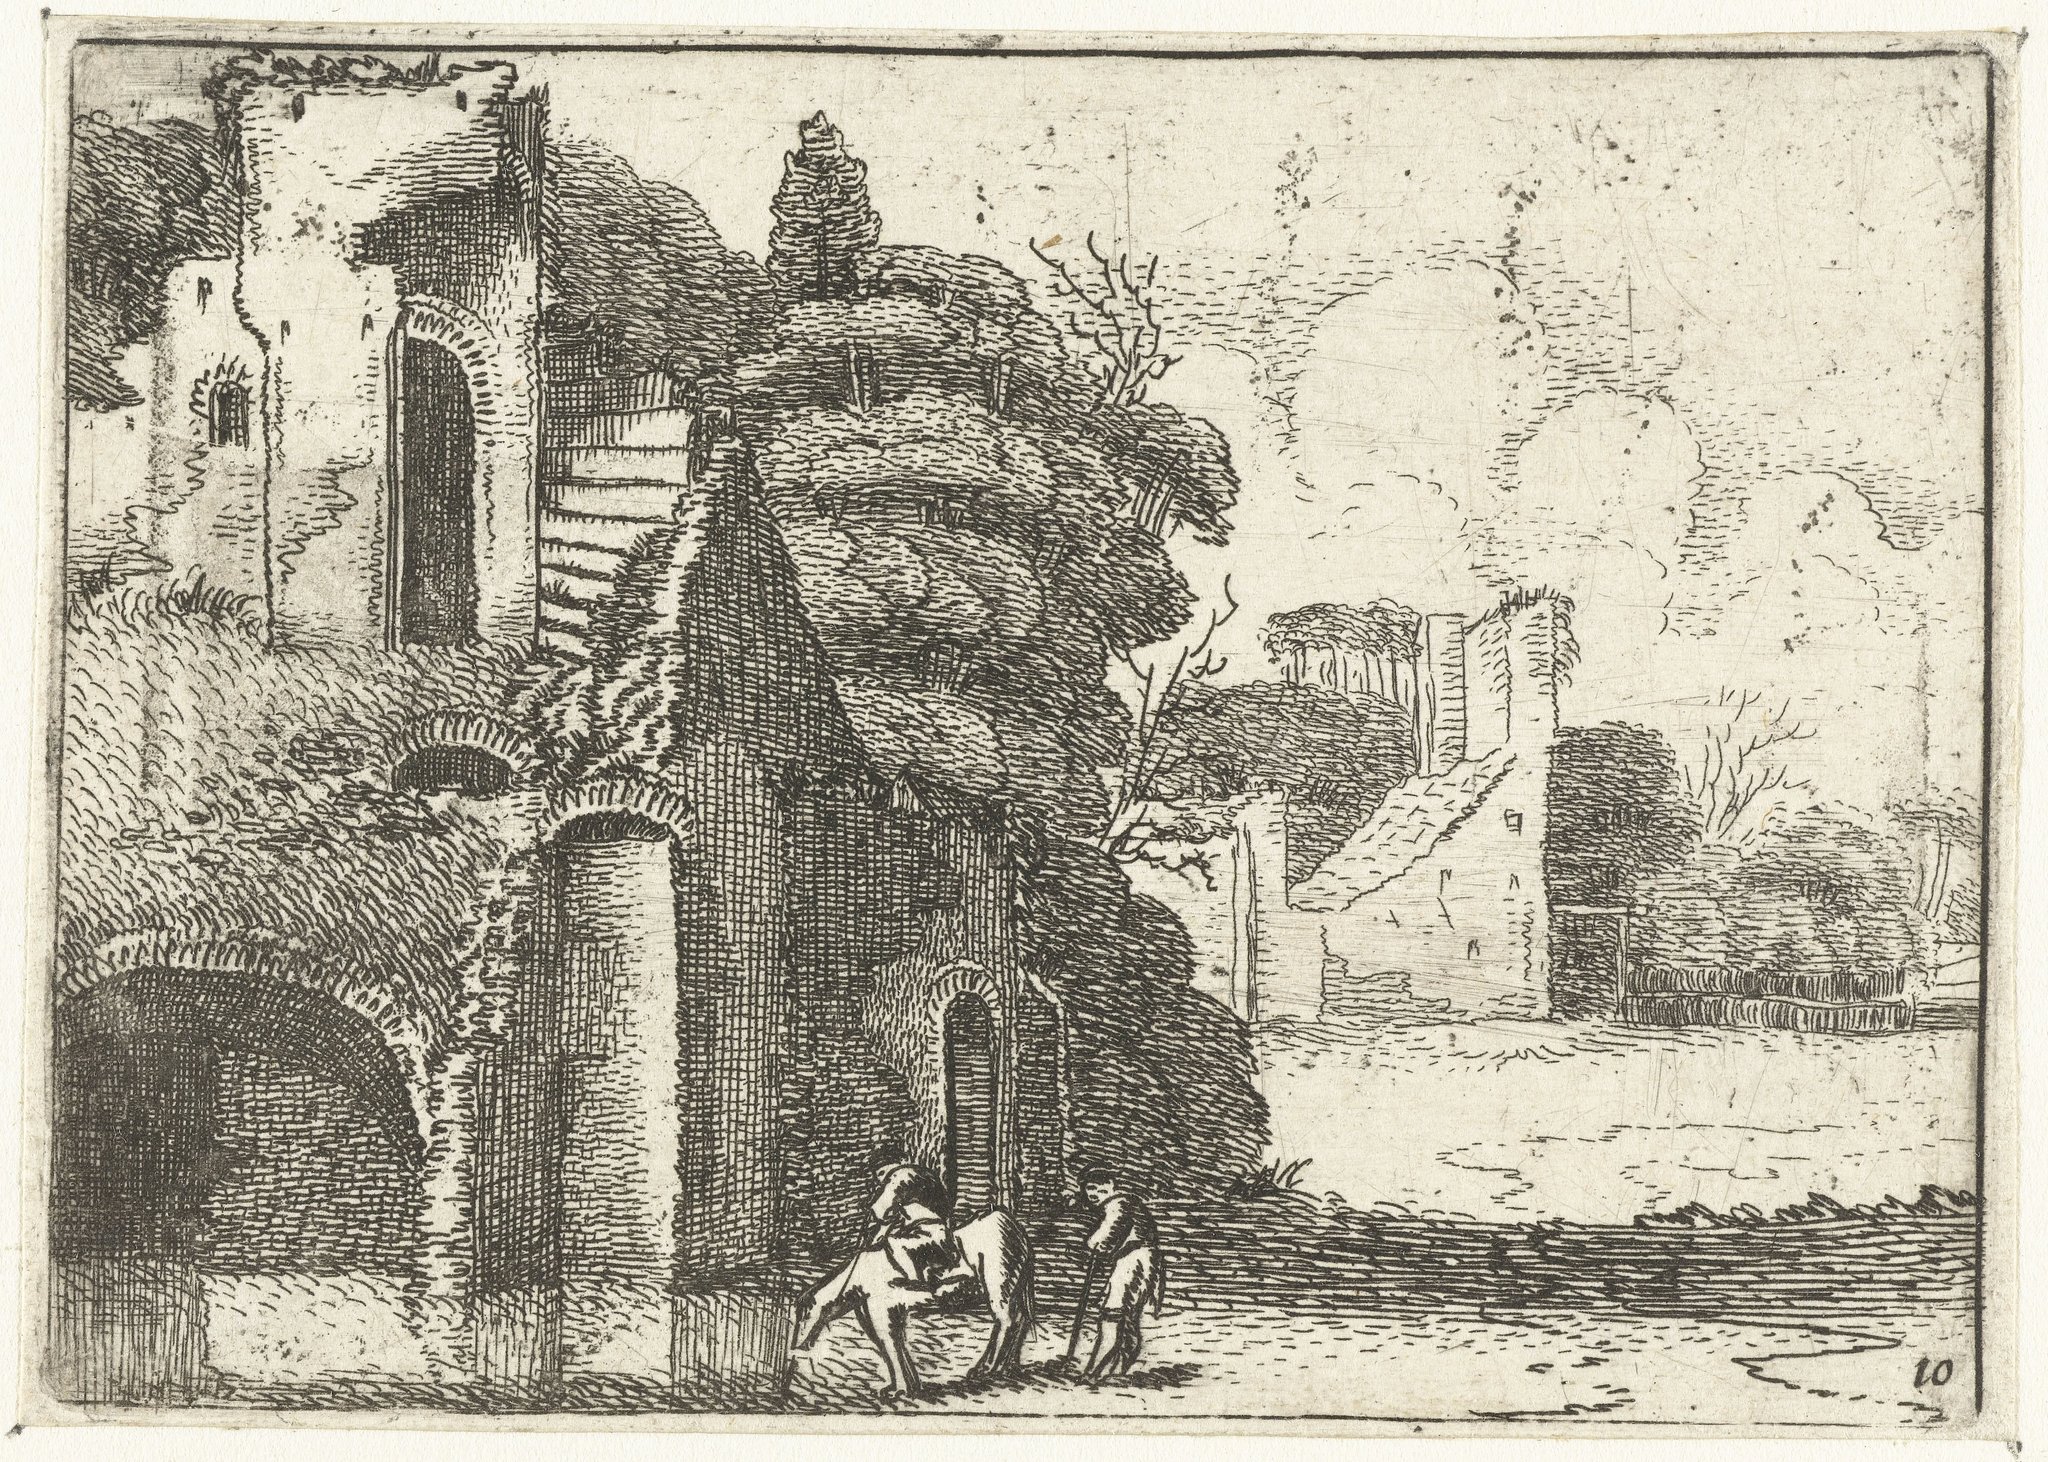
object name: print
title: Drinkend paard bij ruïnes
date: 1603-1641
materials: paper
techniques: etching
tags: landscape with ruins, horse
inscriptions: collector's mark: Lugt 2227